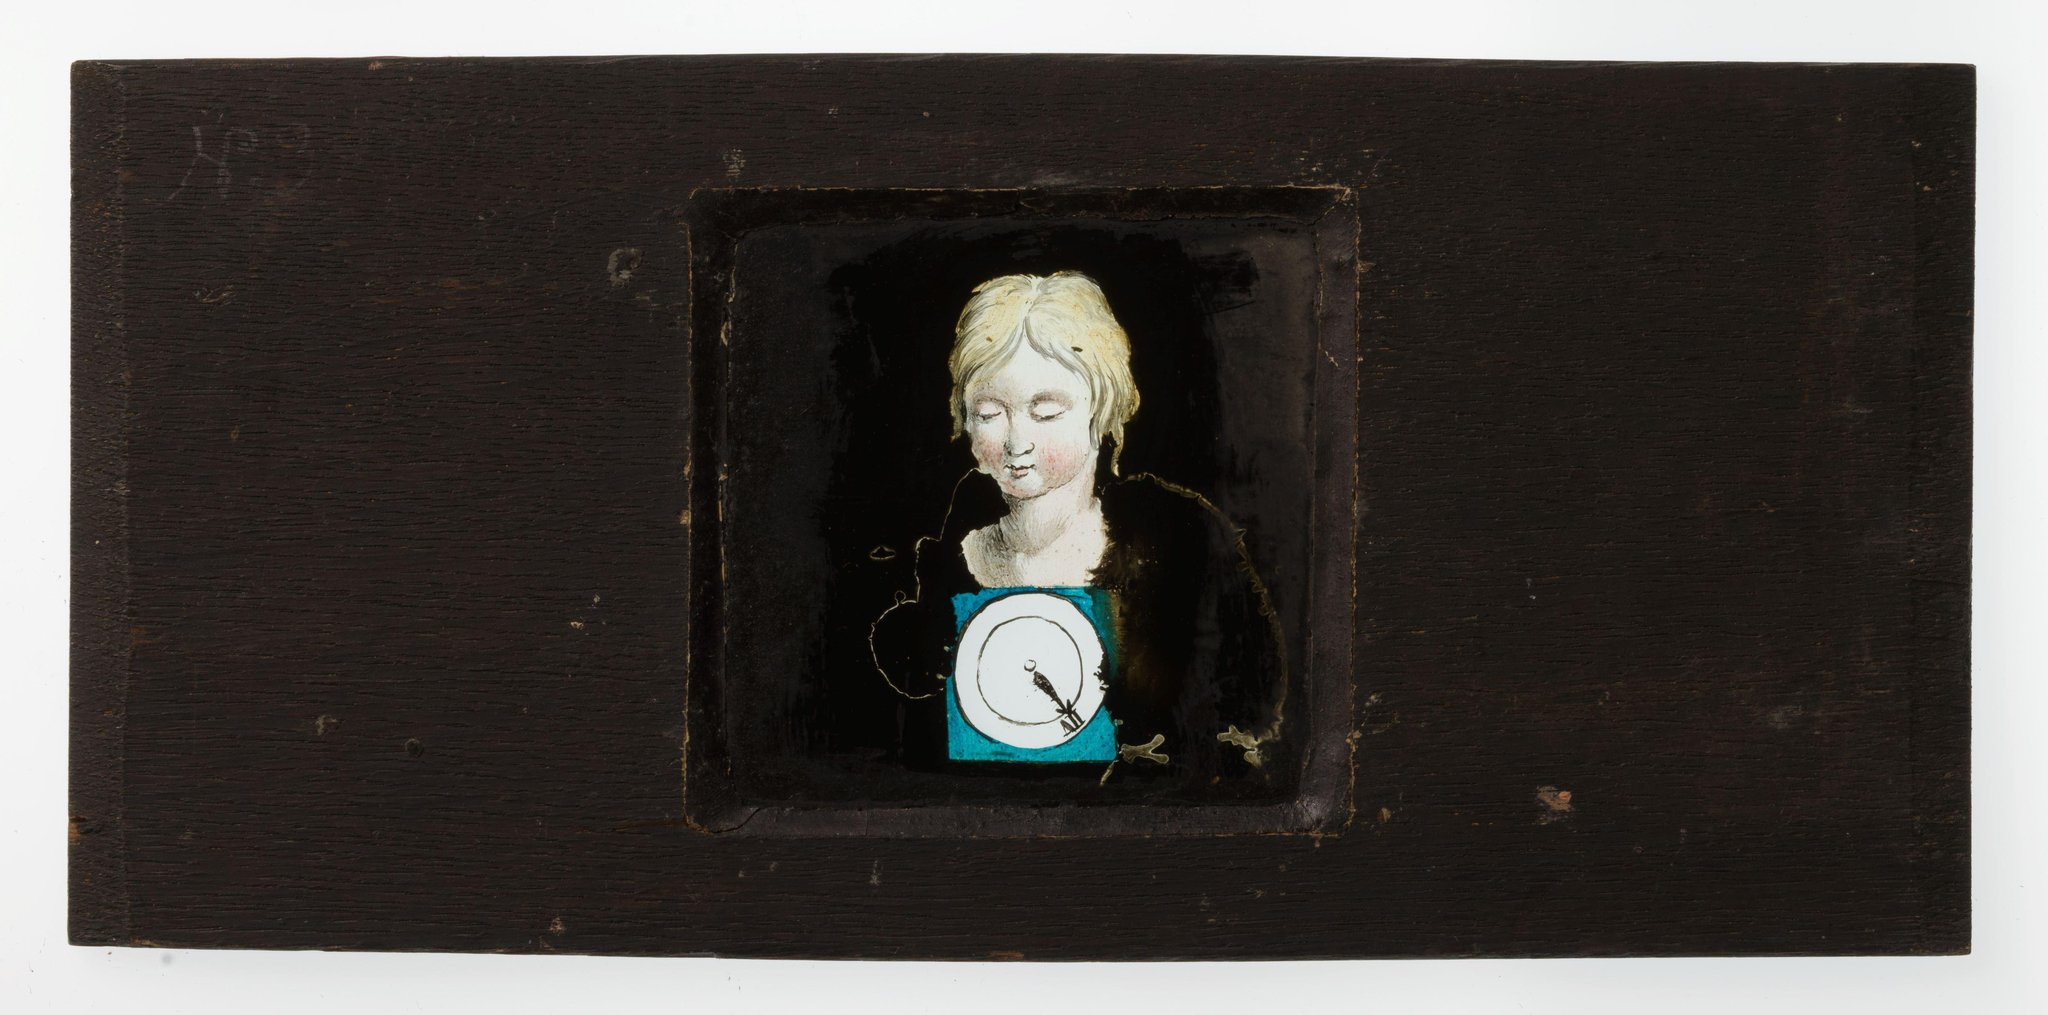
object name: lantern slide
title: Klok en buste van jongen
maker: Anonymous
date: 1790-1830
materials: glass, wood, oil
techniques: painted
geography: france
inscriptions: label: ‘'Gebrandschilderde glazen. Collectie I.S. van der Schaaff, Baarn. Nummer 43 (drieënveertig) bevattende één glas, voorstellendeeen buste eens meisje, waaronder een uurwijzerplaat. Het glas is geheel ongeschonden en gaaf op 13 april 1886.'’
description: Vierkante glasplaat in houten vatting. Buste van een jongen met gesloten ogen. Daaronder een klok die op zeven uur staat. Onderdeel van een serie bustes met klokken die de fasen van het leven verbeelden.